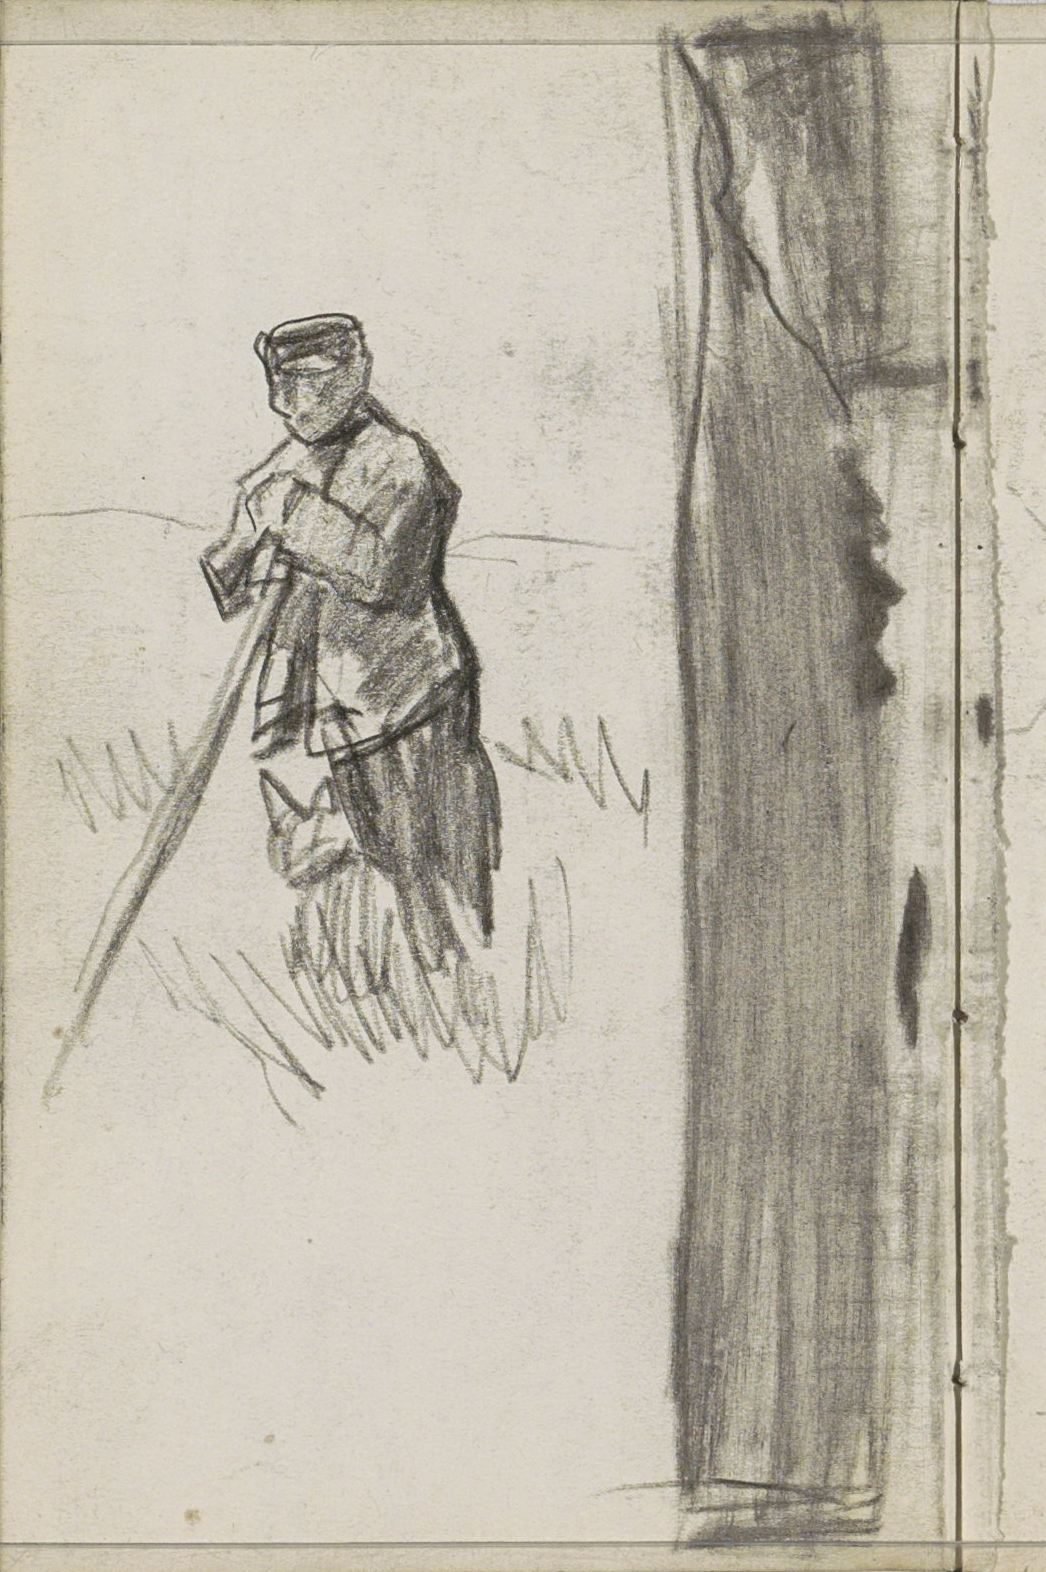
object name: sketchbook leaf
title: Arbeider leunend op de steel van een stuk landbouwgereedschap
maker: anton mauve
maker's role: draughtsman, painter, print maker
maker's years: 1838-1888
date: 1848-1888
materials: chalk, paper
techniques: brush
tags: leaning figure (+ male human being (not to be used where -a- is prescribed)), working class, labourers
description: Blad 16 verso uit een schetsboek met 53 bladen.